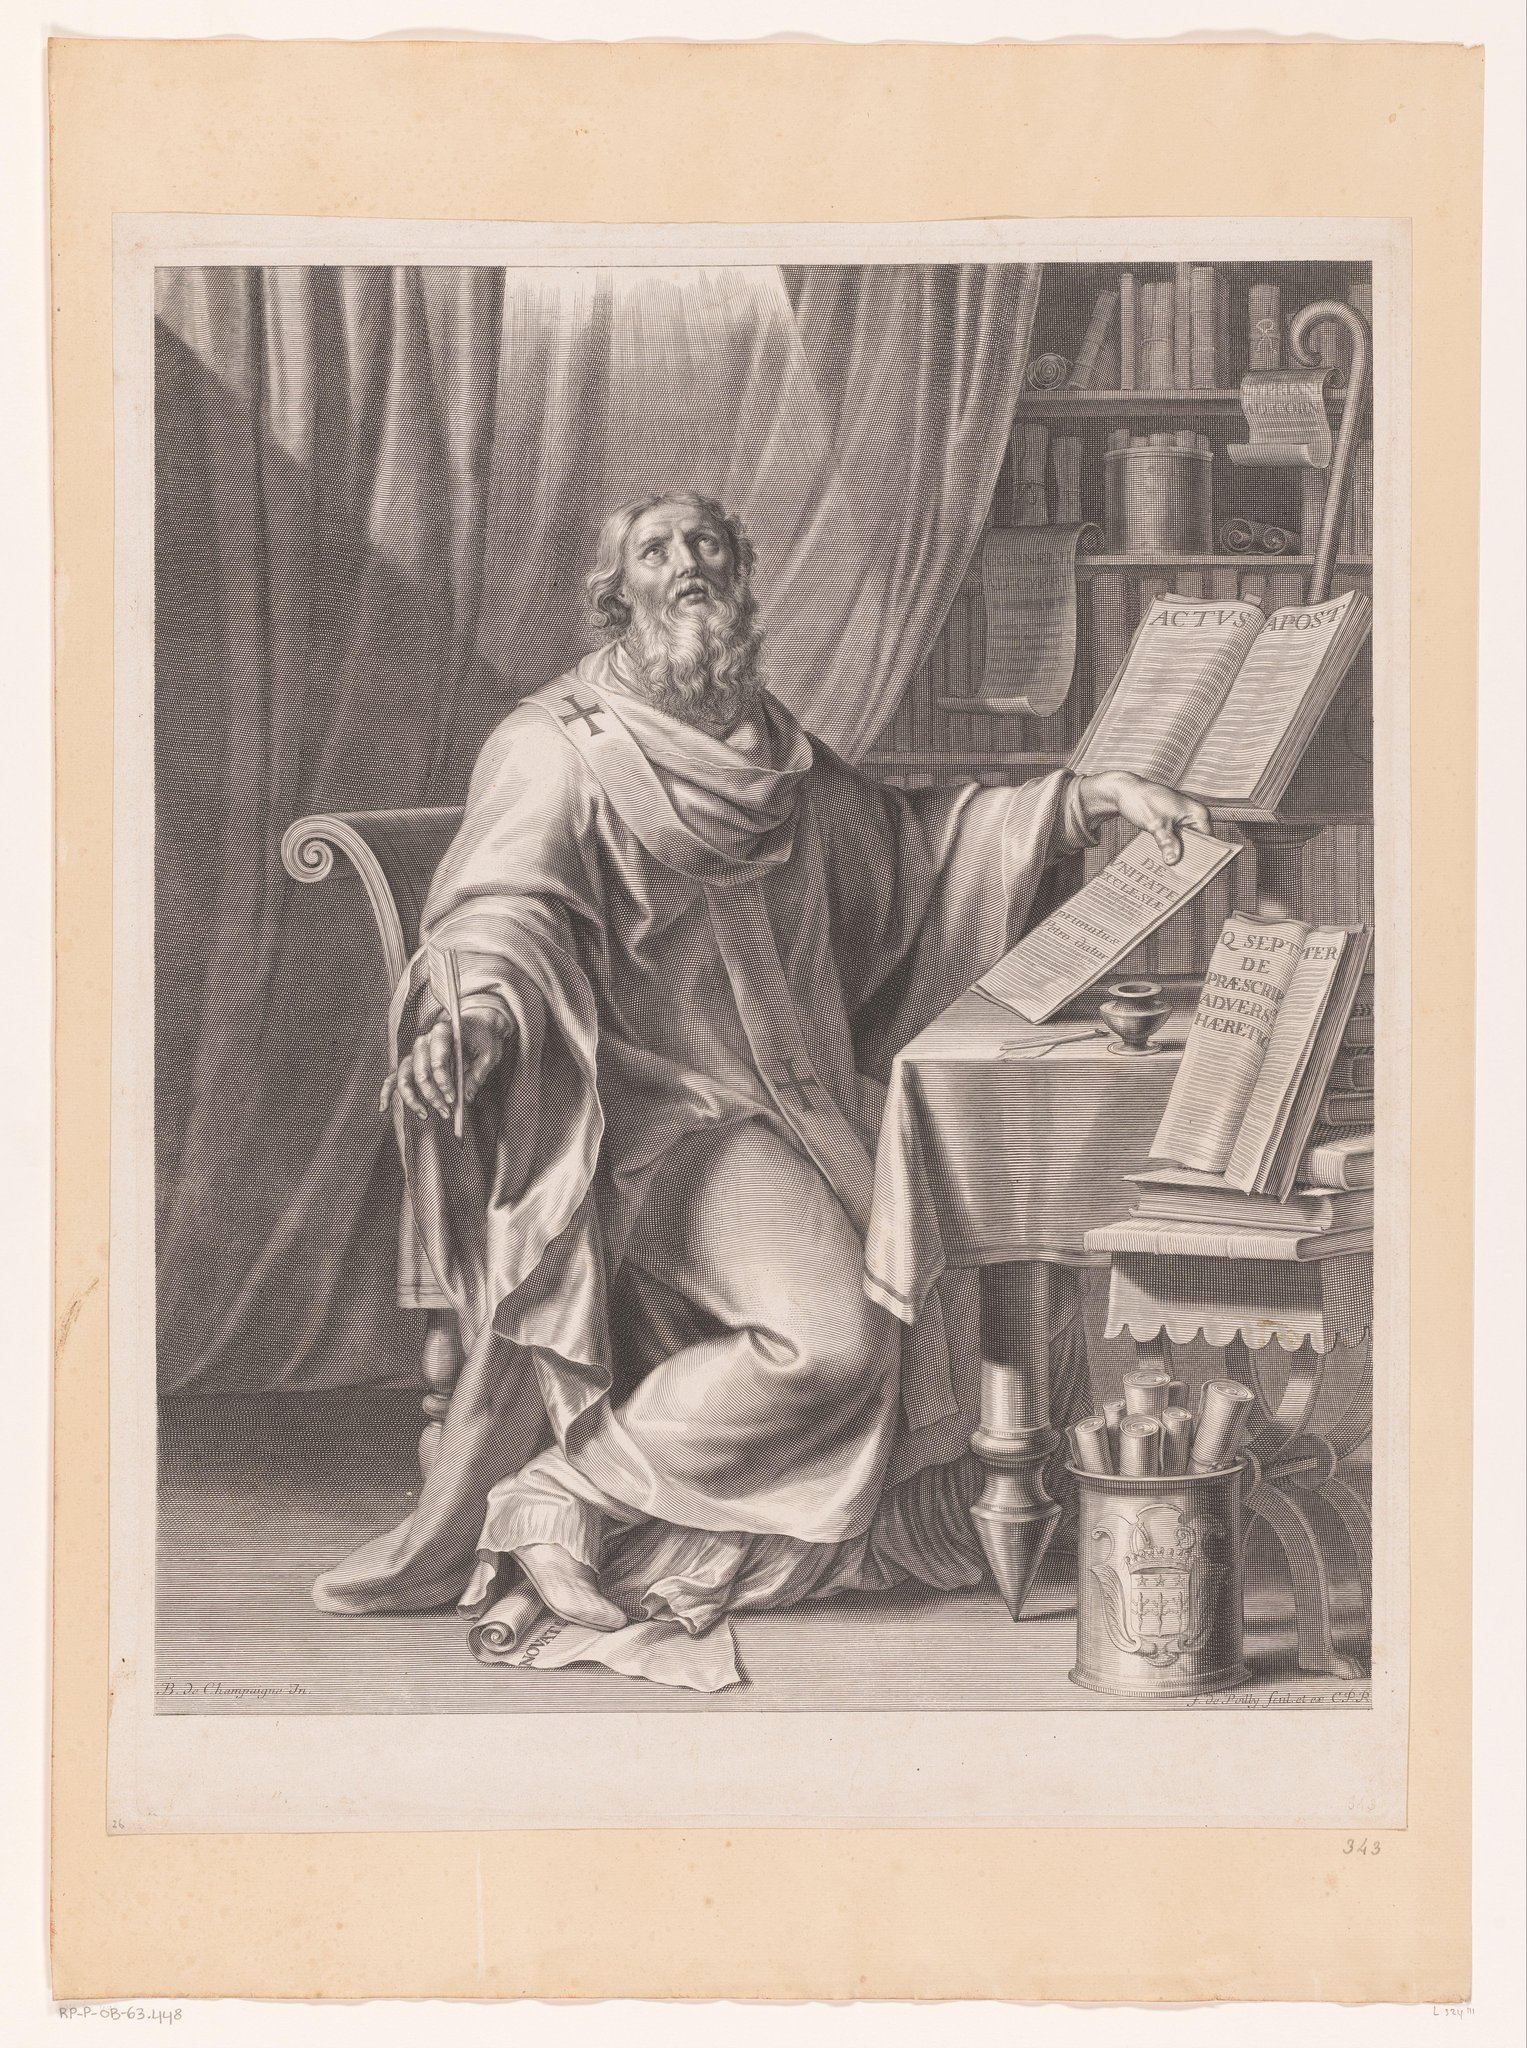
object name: print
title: Heilige Johannes Chrysostomus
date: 1665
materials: paper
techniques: engraving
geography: france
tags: st. john chrysostom as doctor of the greek church, writing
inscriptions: collector's mark: Lugt 240